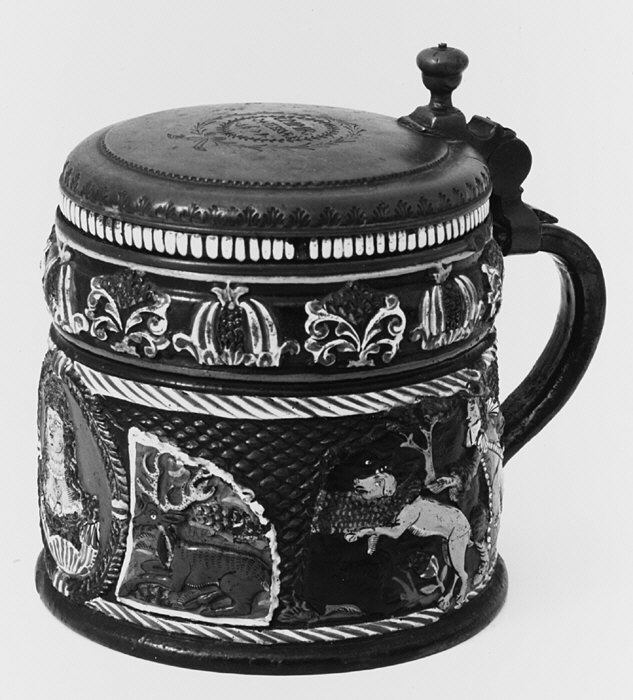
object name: tankard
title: Hunting tankard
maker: george schöps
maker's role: maker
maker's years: 1625-1725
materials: pewter, stoneware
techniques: salt glaze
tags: animals,hunting